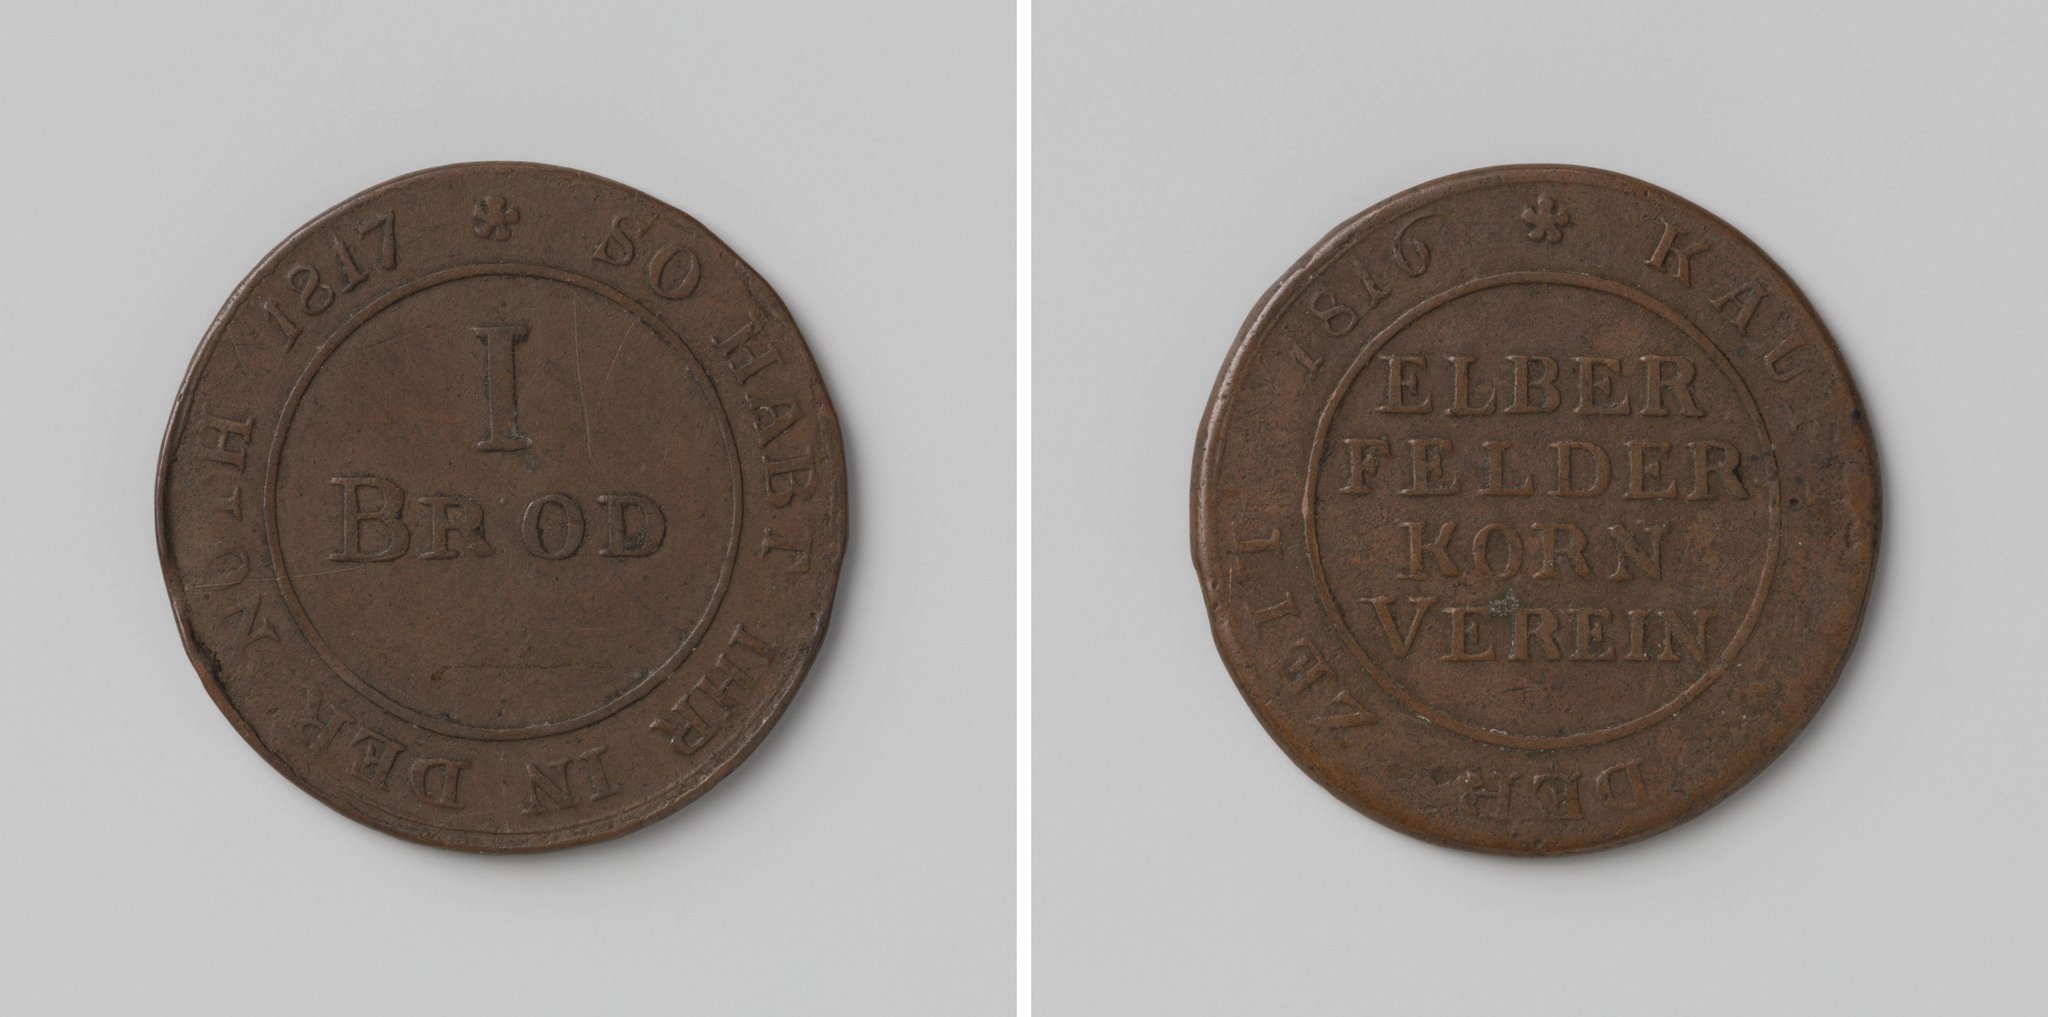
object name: bread token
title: Elberfelder Kornverein, loodje goed voor een brood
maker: Anonymous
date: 1817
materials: copper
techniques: striking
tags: elberfeld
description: Koperen penning. Voorzijde: opschrift binnen omschrift. Keerzijde: opschrift binnen omschrift